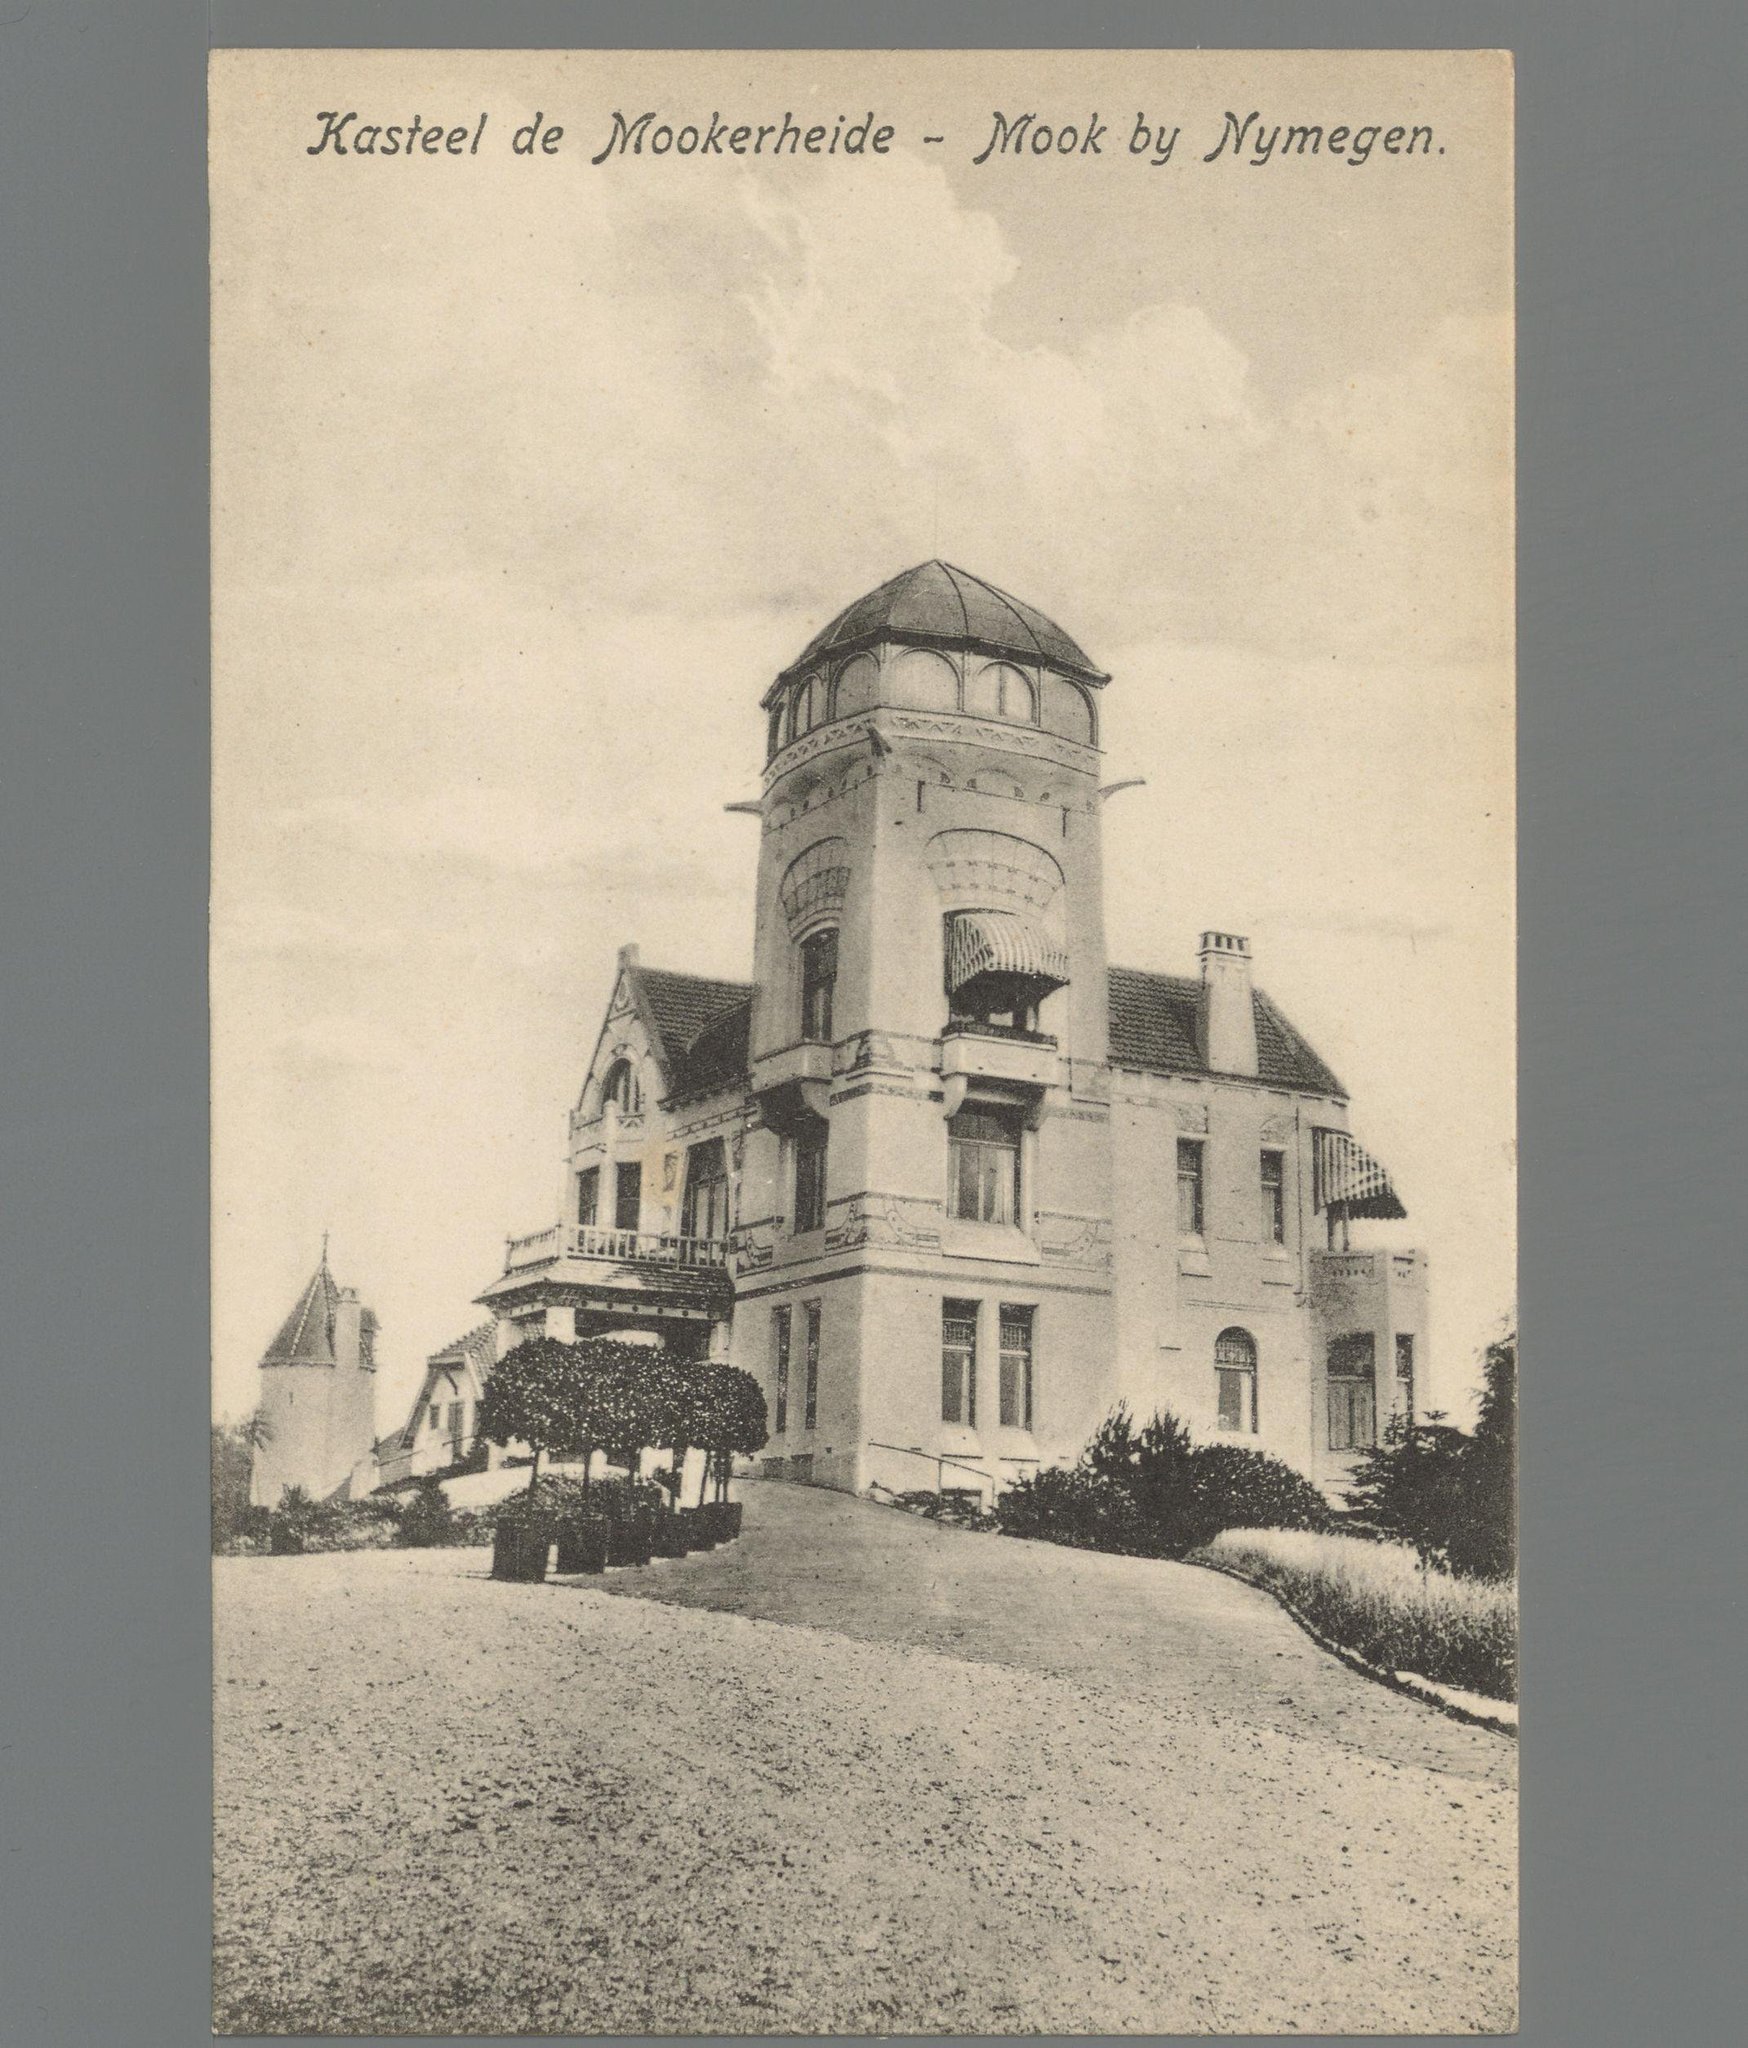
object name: photomechanical print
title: Kasteel de Mookerheide - Mook by Nymegen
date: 1910-1930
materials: cardboard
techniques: photograph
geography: mook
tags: castle